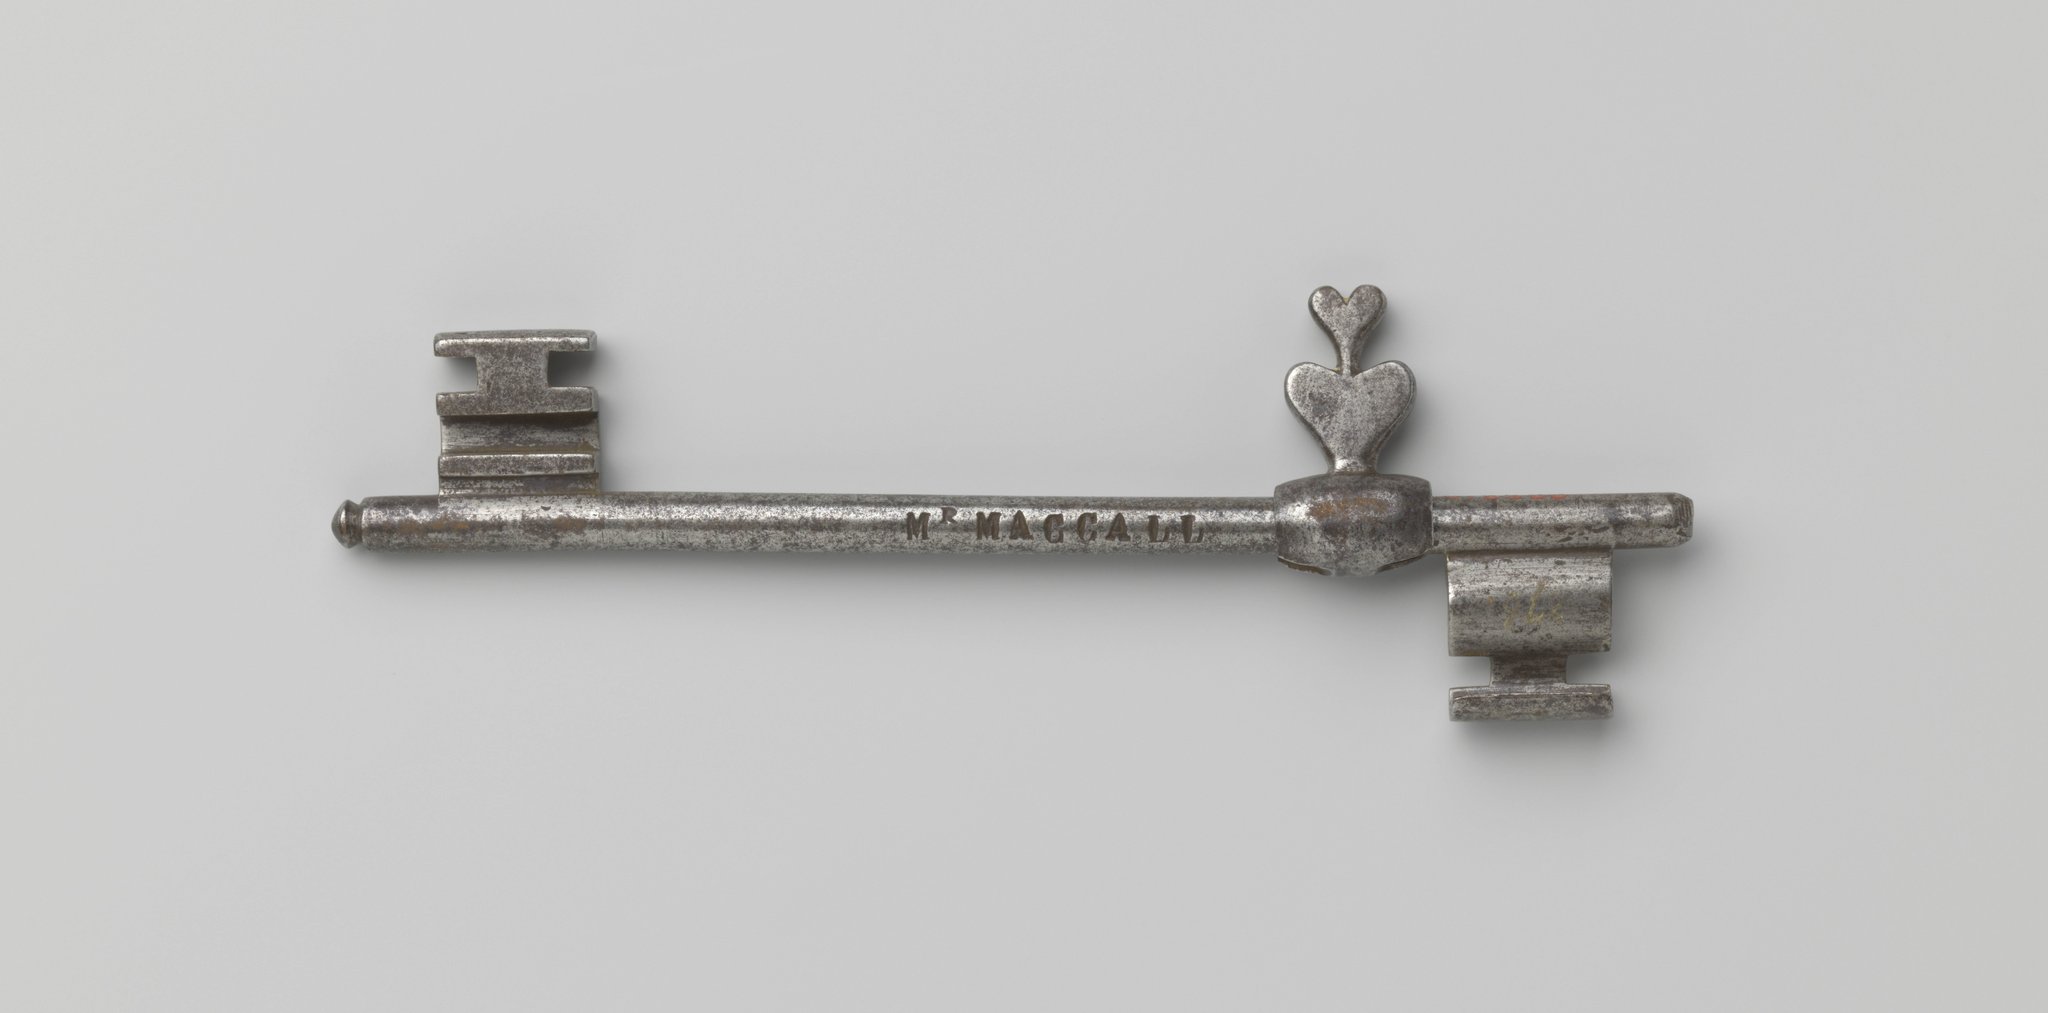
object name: key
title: Dubbele sleutel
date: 1800-1900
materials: iron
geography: england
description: Dubbele sleutel met aan beide uiteinden van de schacht een baard. De verschuifbare greep bestaat uit een tonusvormige cylinder met twee op elkaar geplaatste hartjes die om de schacht schuiven.